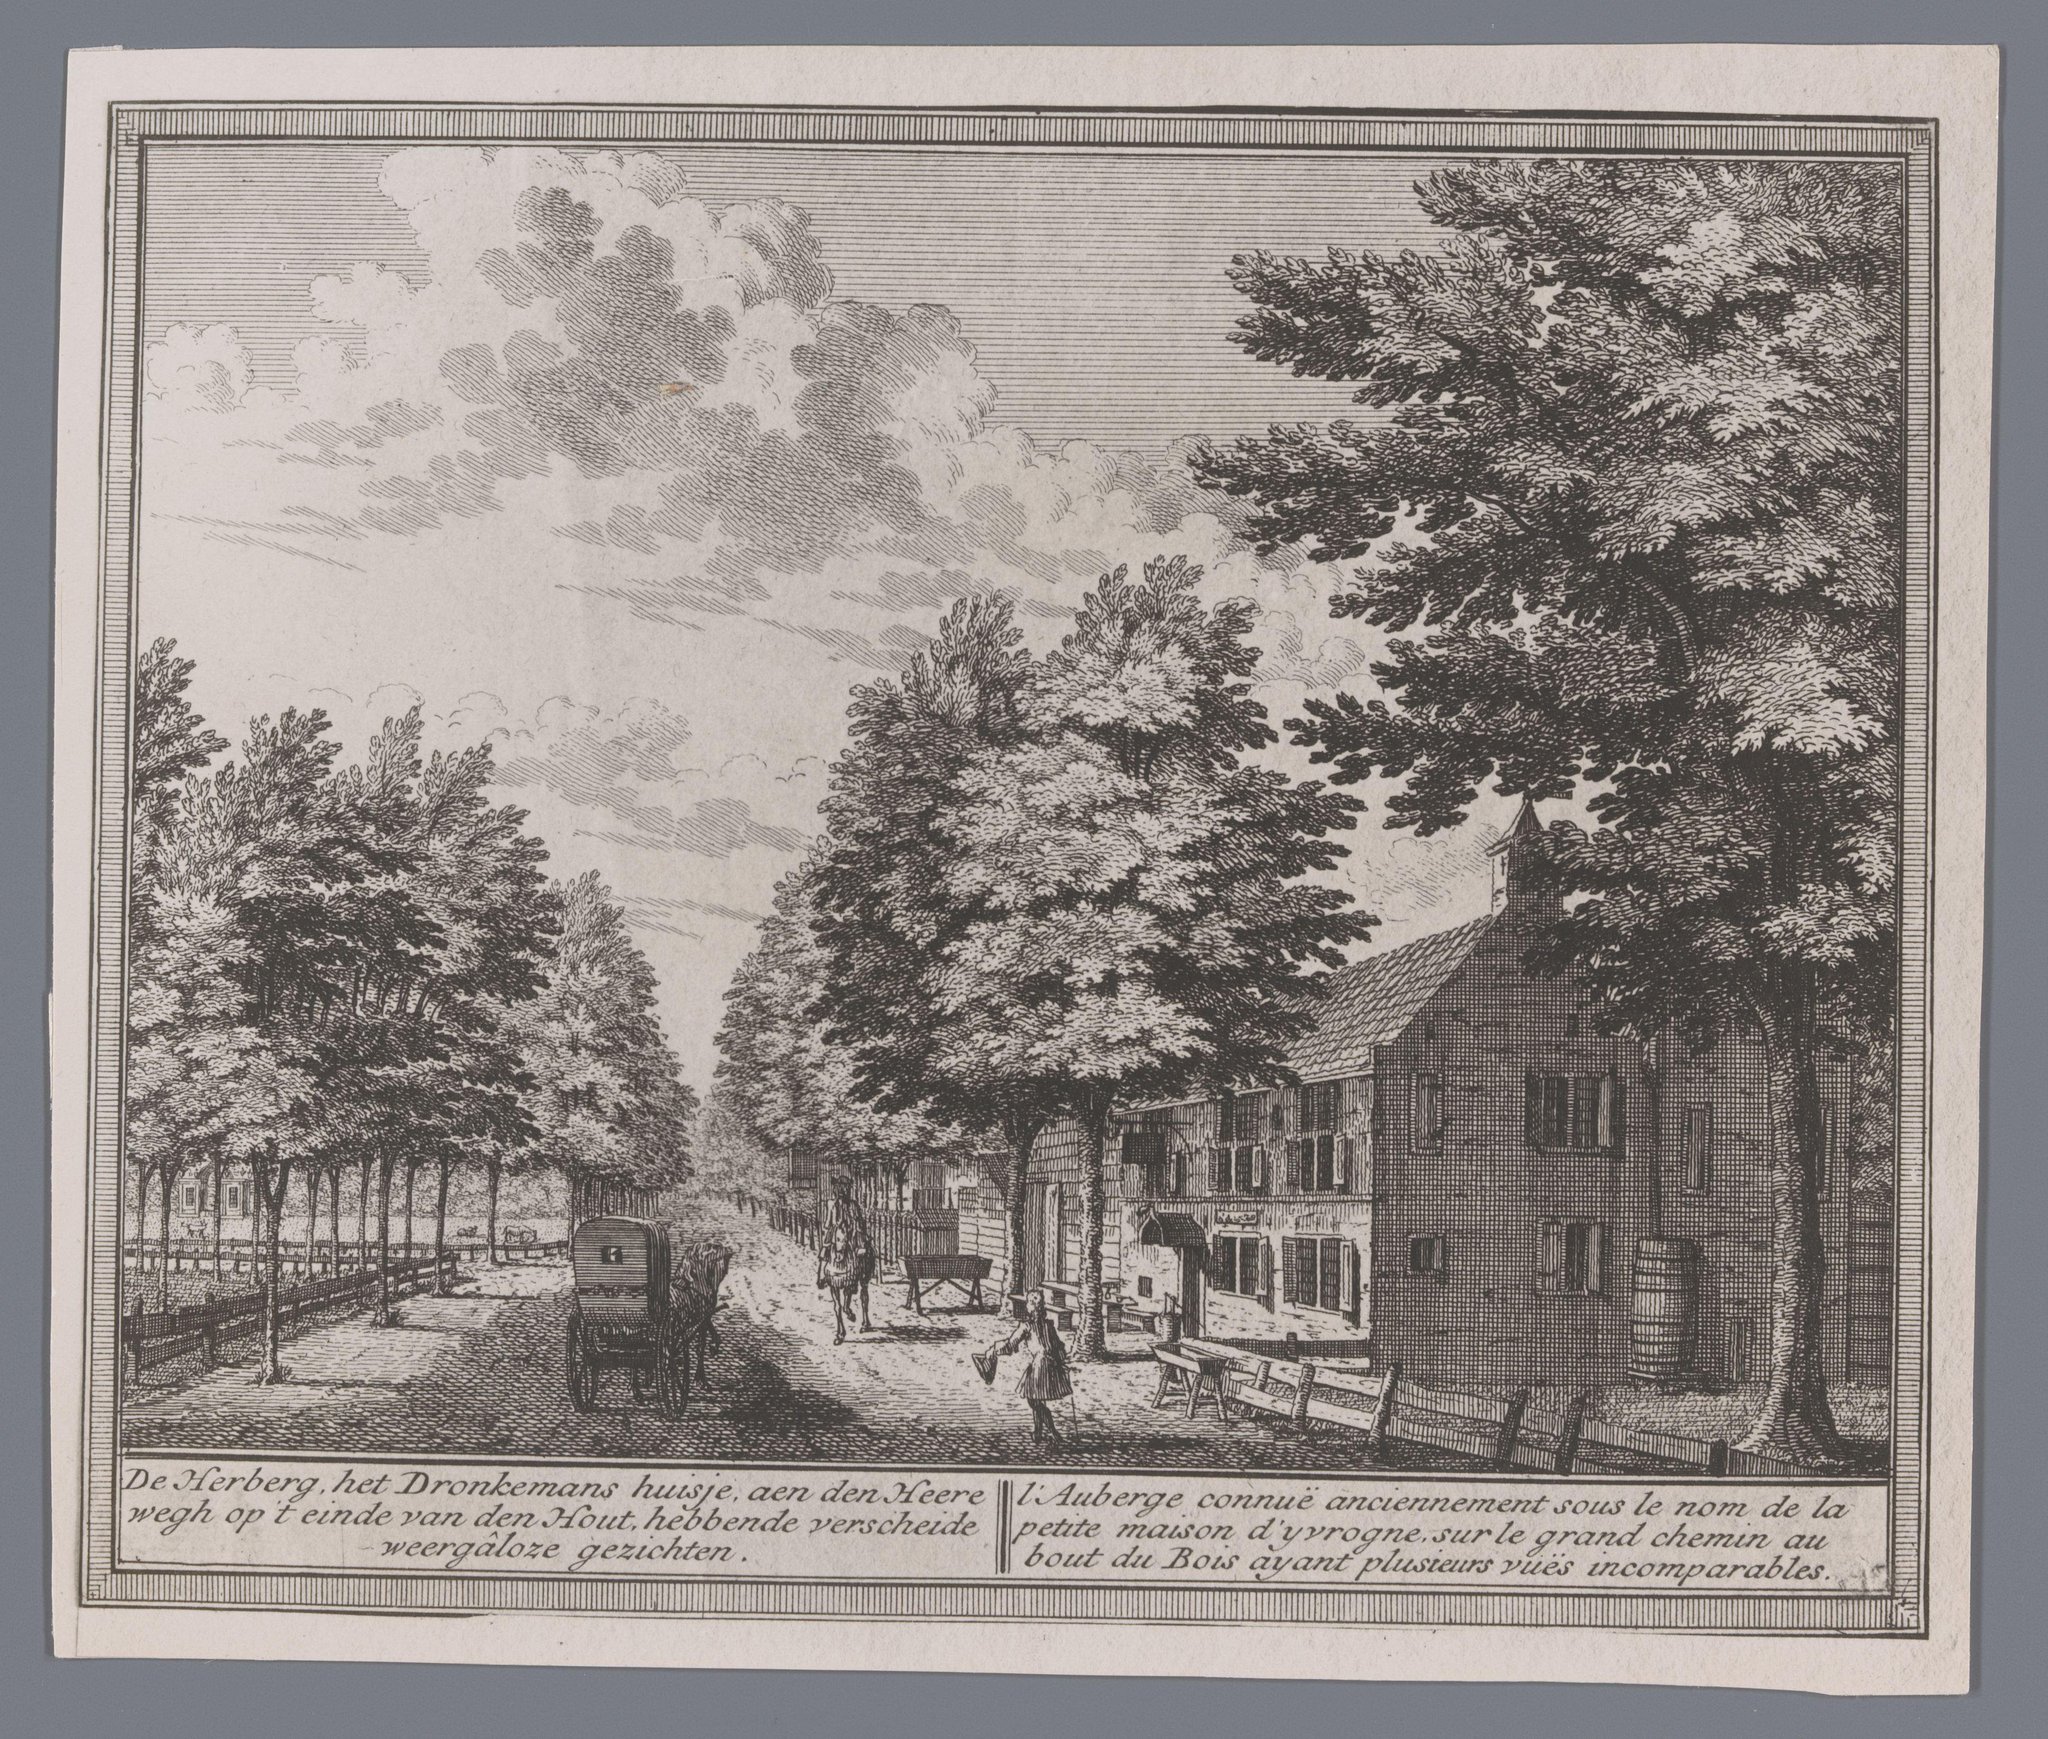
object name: photograph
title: Fotoreproductie van een prent van een herberg in de Haarlemmerhout te Haarlem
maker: Anonymous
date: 1900-1930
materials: photographic support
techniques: gelatin silver print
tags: street (+ city(-scape) with figures, staffage), haarlem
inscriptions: annotation: ‘Haarlem’, inscription: ‘De Herberg het Dronkemans huisje aen den Heere wegh op 't einde van den Hout, hebbende verscheide weergaloze gezichten’, number: ‘'22.41.’, collector's mark: Lugt 2233